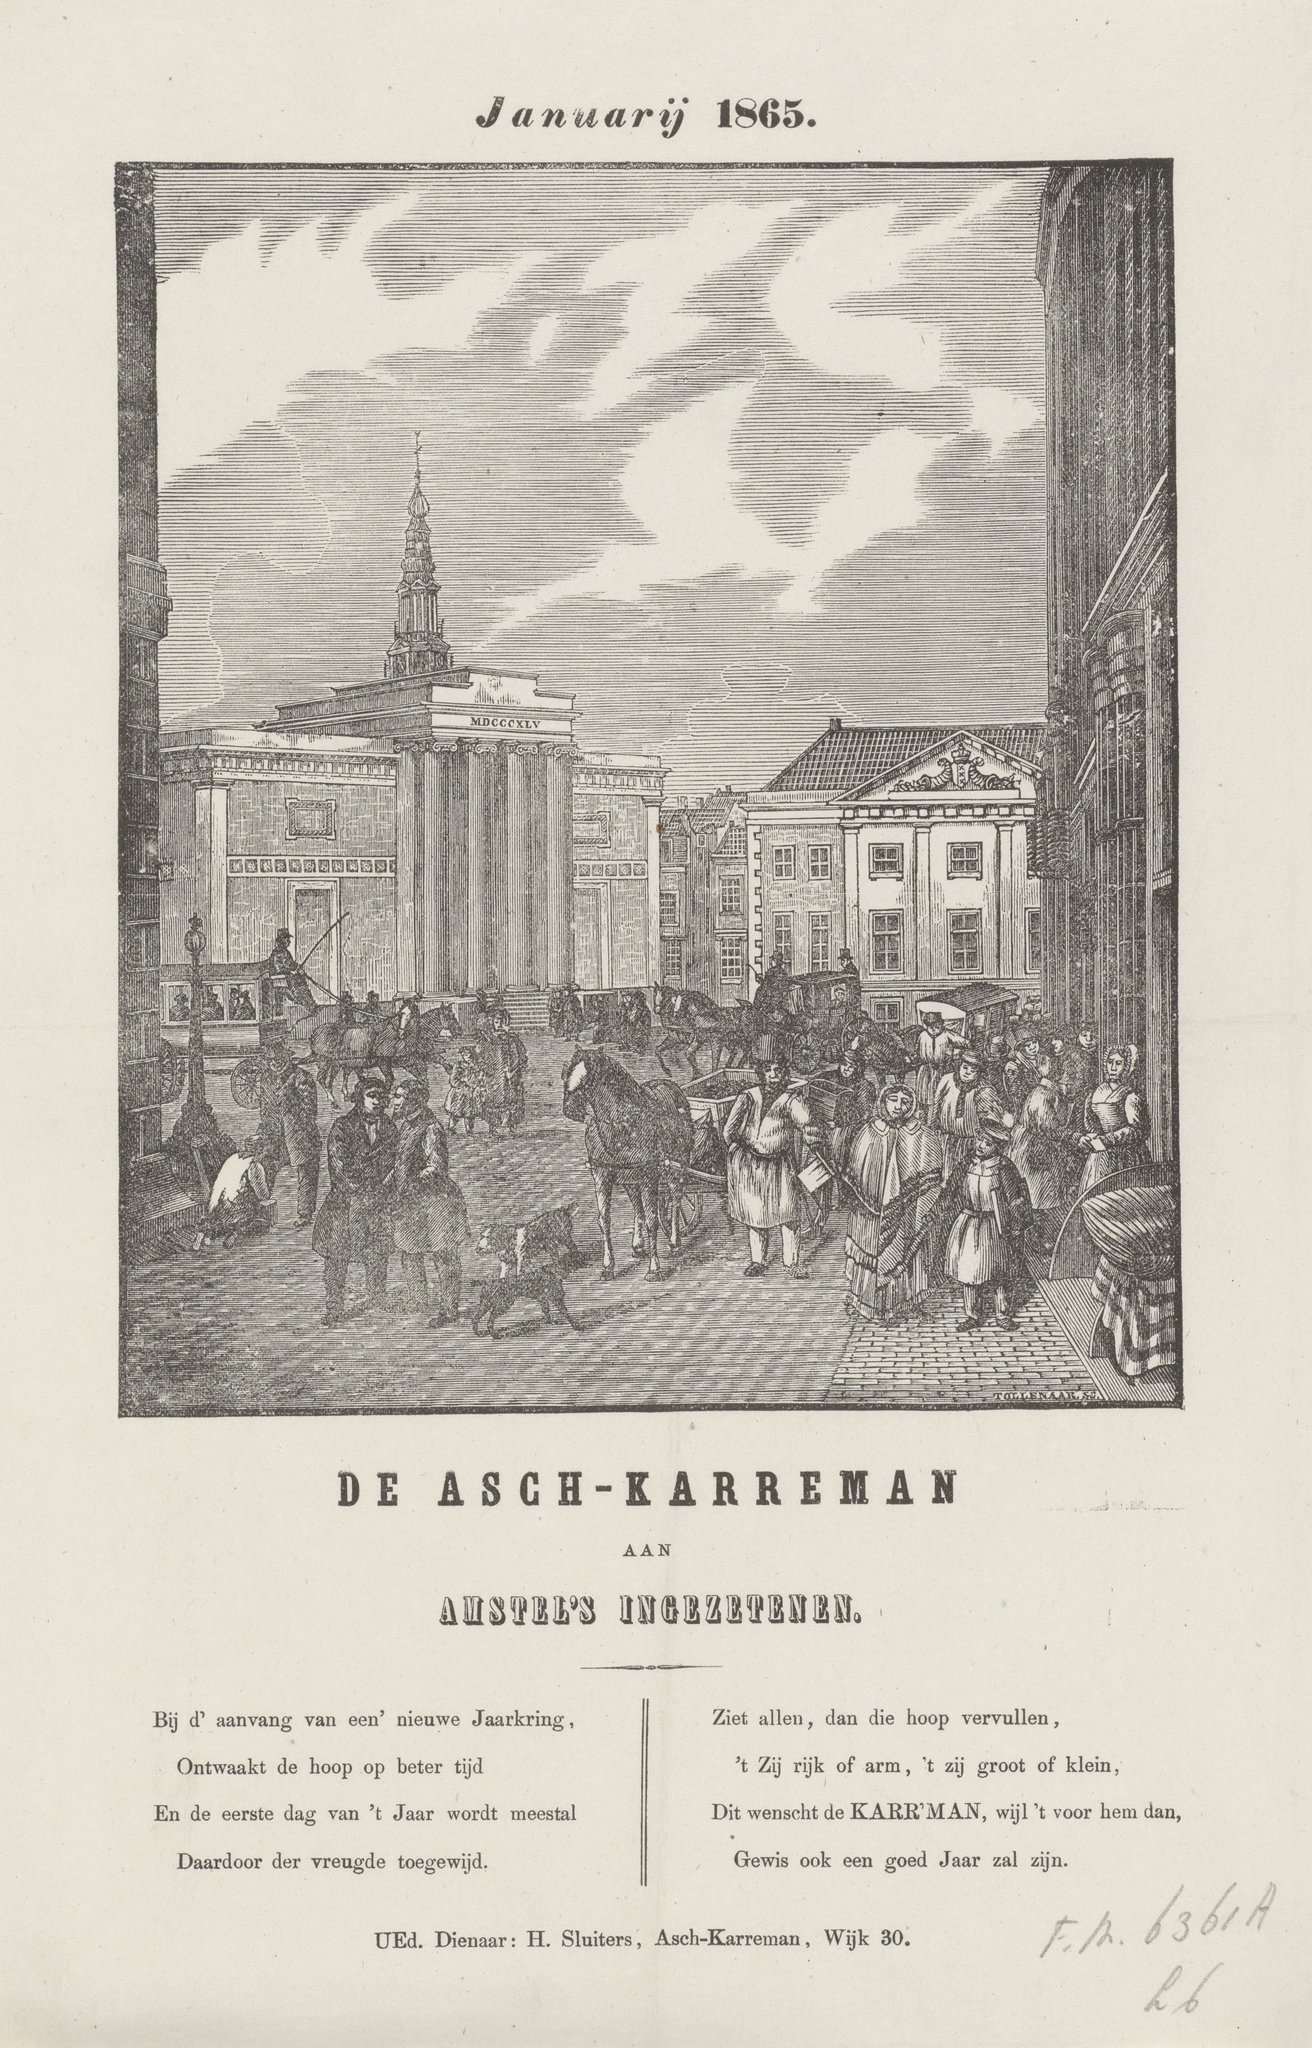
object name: print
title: Januarij 1865 / De Asch-Karreman aan Amstel's Ingezetenen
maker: dirk wijbrand tollenaar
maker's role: print maker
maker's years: 1808-1858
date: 1864-1865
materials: paper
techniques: letterpress printing, engraving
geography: netherlands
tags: public road - ii - ideal city, garbage collection, amsterdam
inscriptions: collector's mark: Lugt 2228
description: Nieuwjaarswens namens de askarrenmannen (karrenman of vuilnisman) te Amsterdam voor het jaar 1865. Gezicht op de Dam te Amsterdam met de Beurs van Zocher en het Commandantshuis. Tussen het publiek de vuilnismannen met hun kar. Onderaan een gedicht in twee kolommen. Namens H. Sluiters, de askarreman van wijk no. 30.